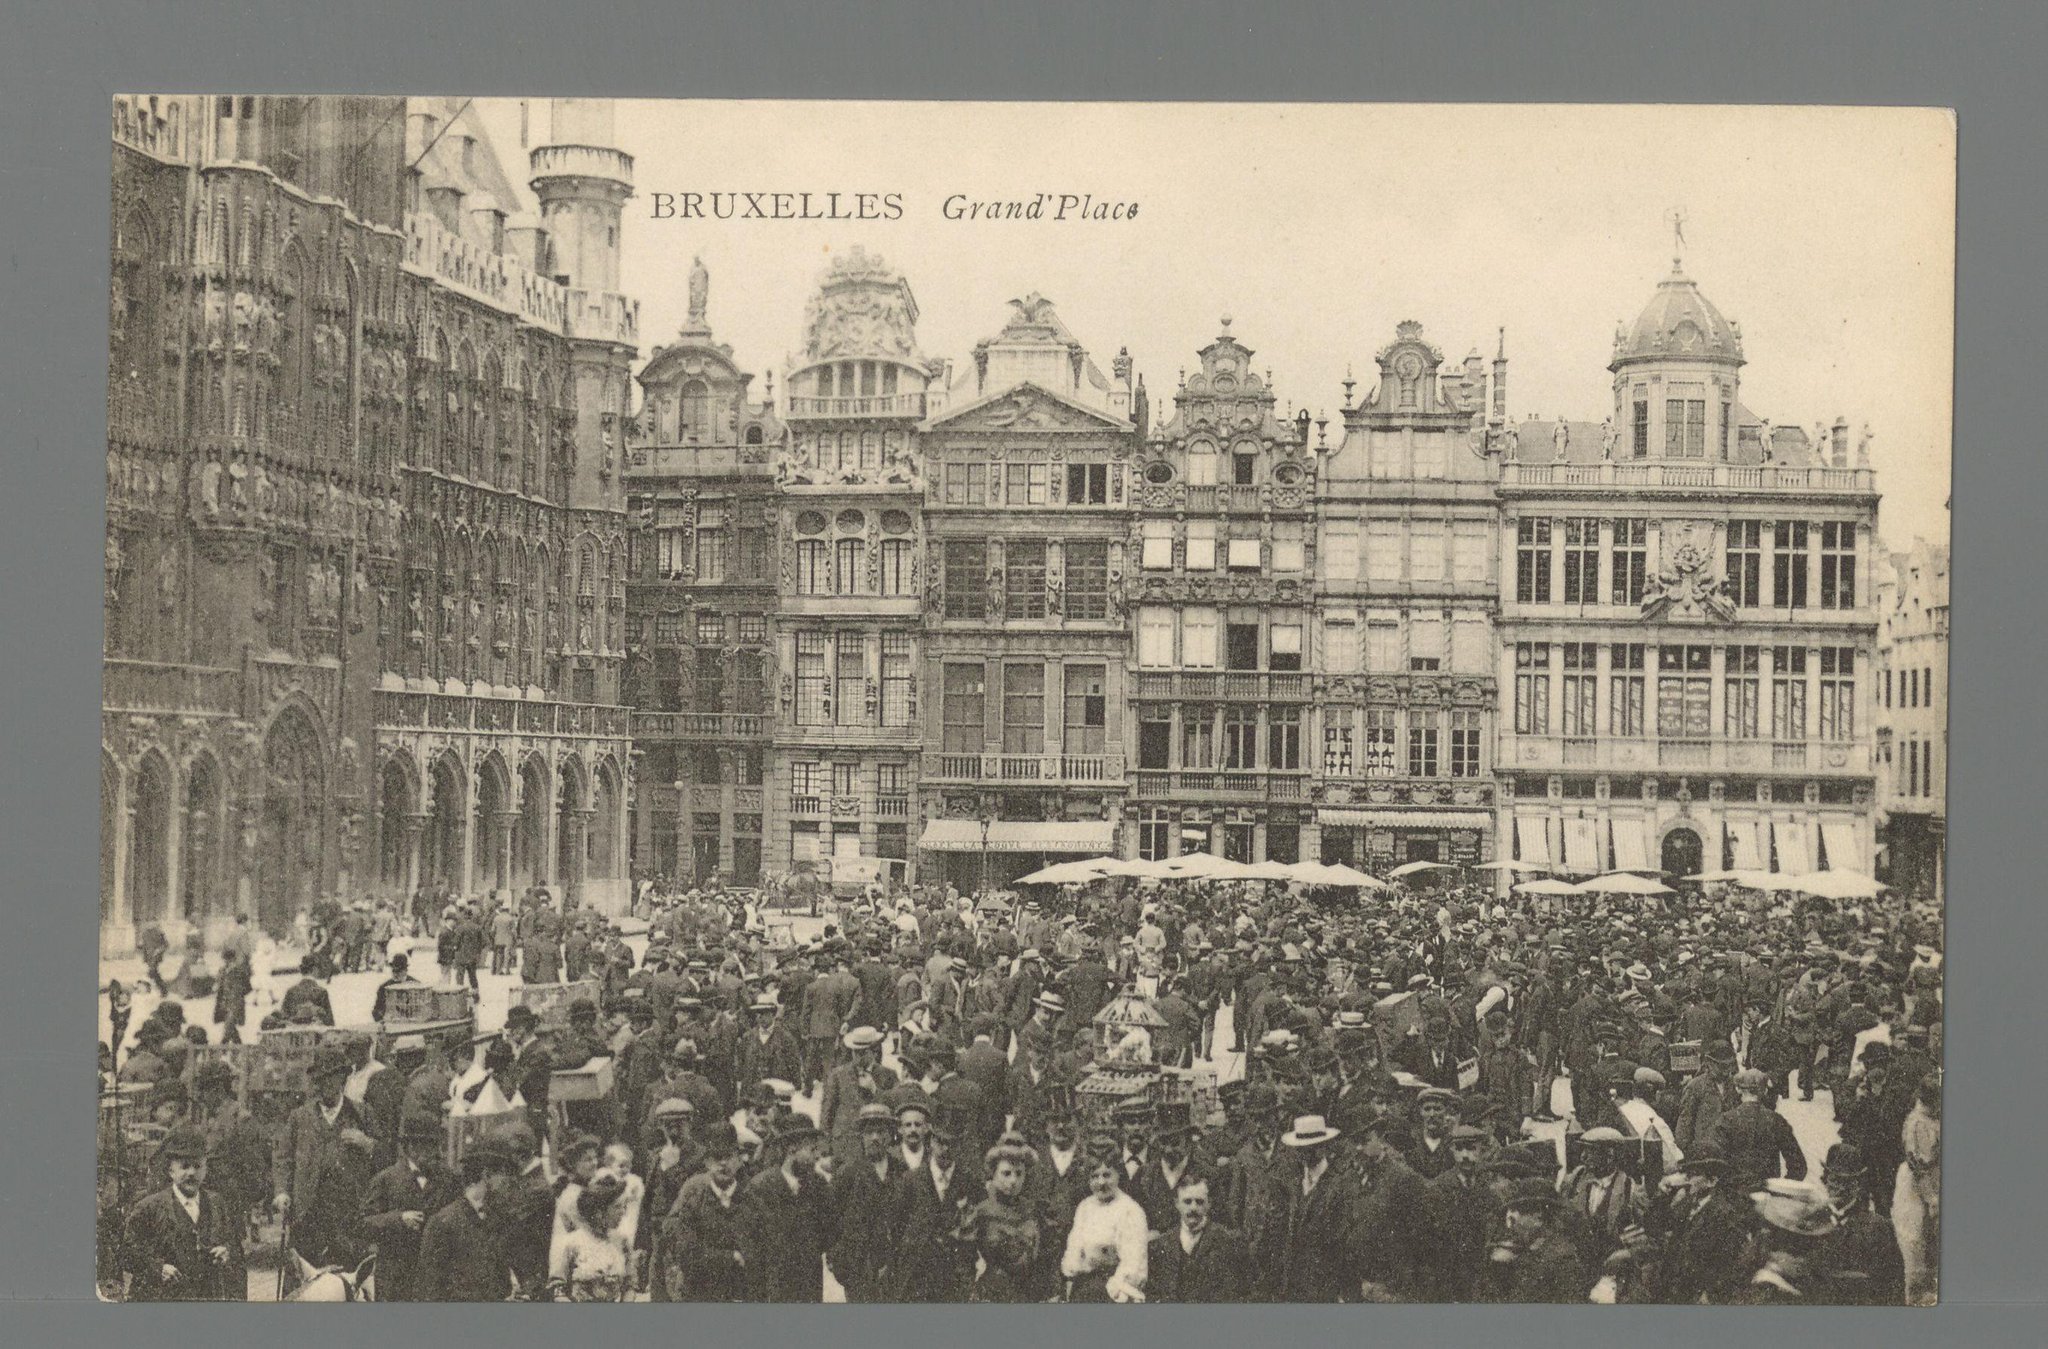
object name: photomechanical print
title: Bruxelles. Grand'Place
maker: Anonymous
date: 1906-1930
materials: cardboard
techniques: photograph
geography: brussels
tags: square, place, circus, etc., city-view, and landscape with man-made constructions (+ city(-scape) with figures, staffage)